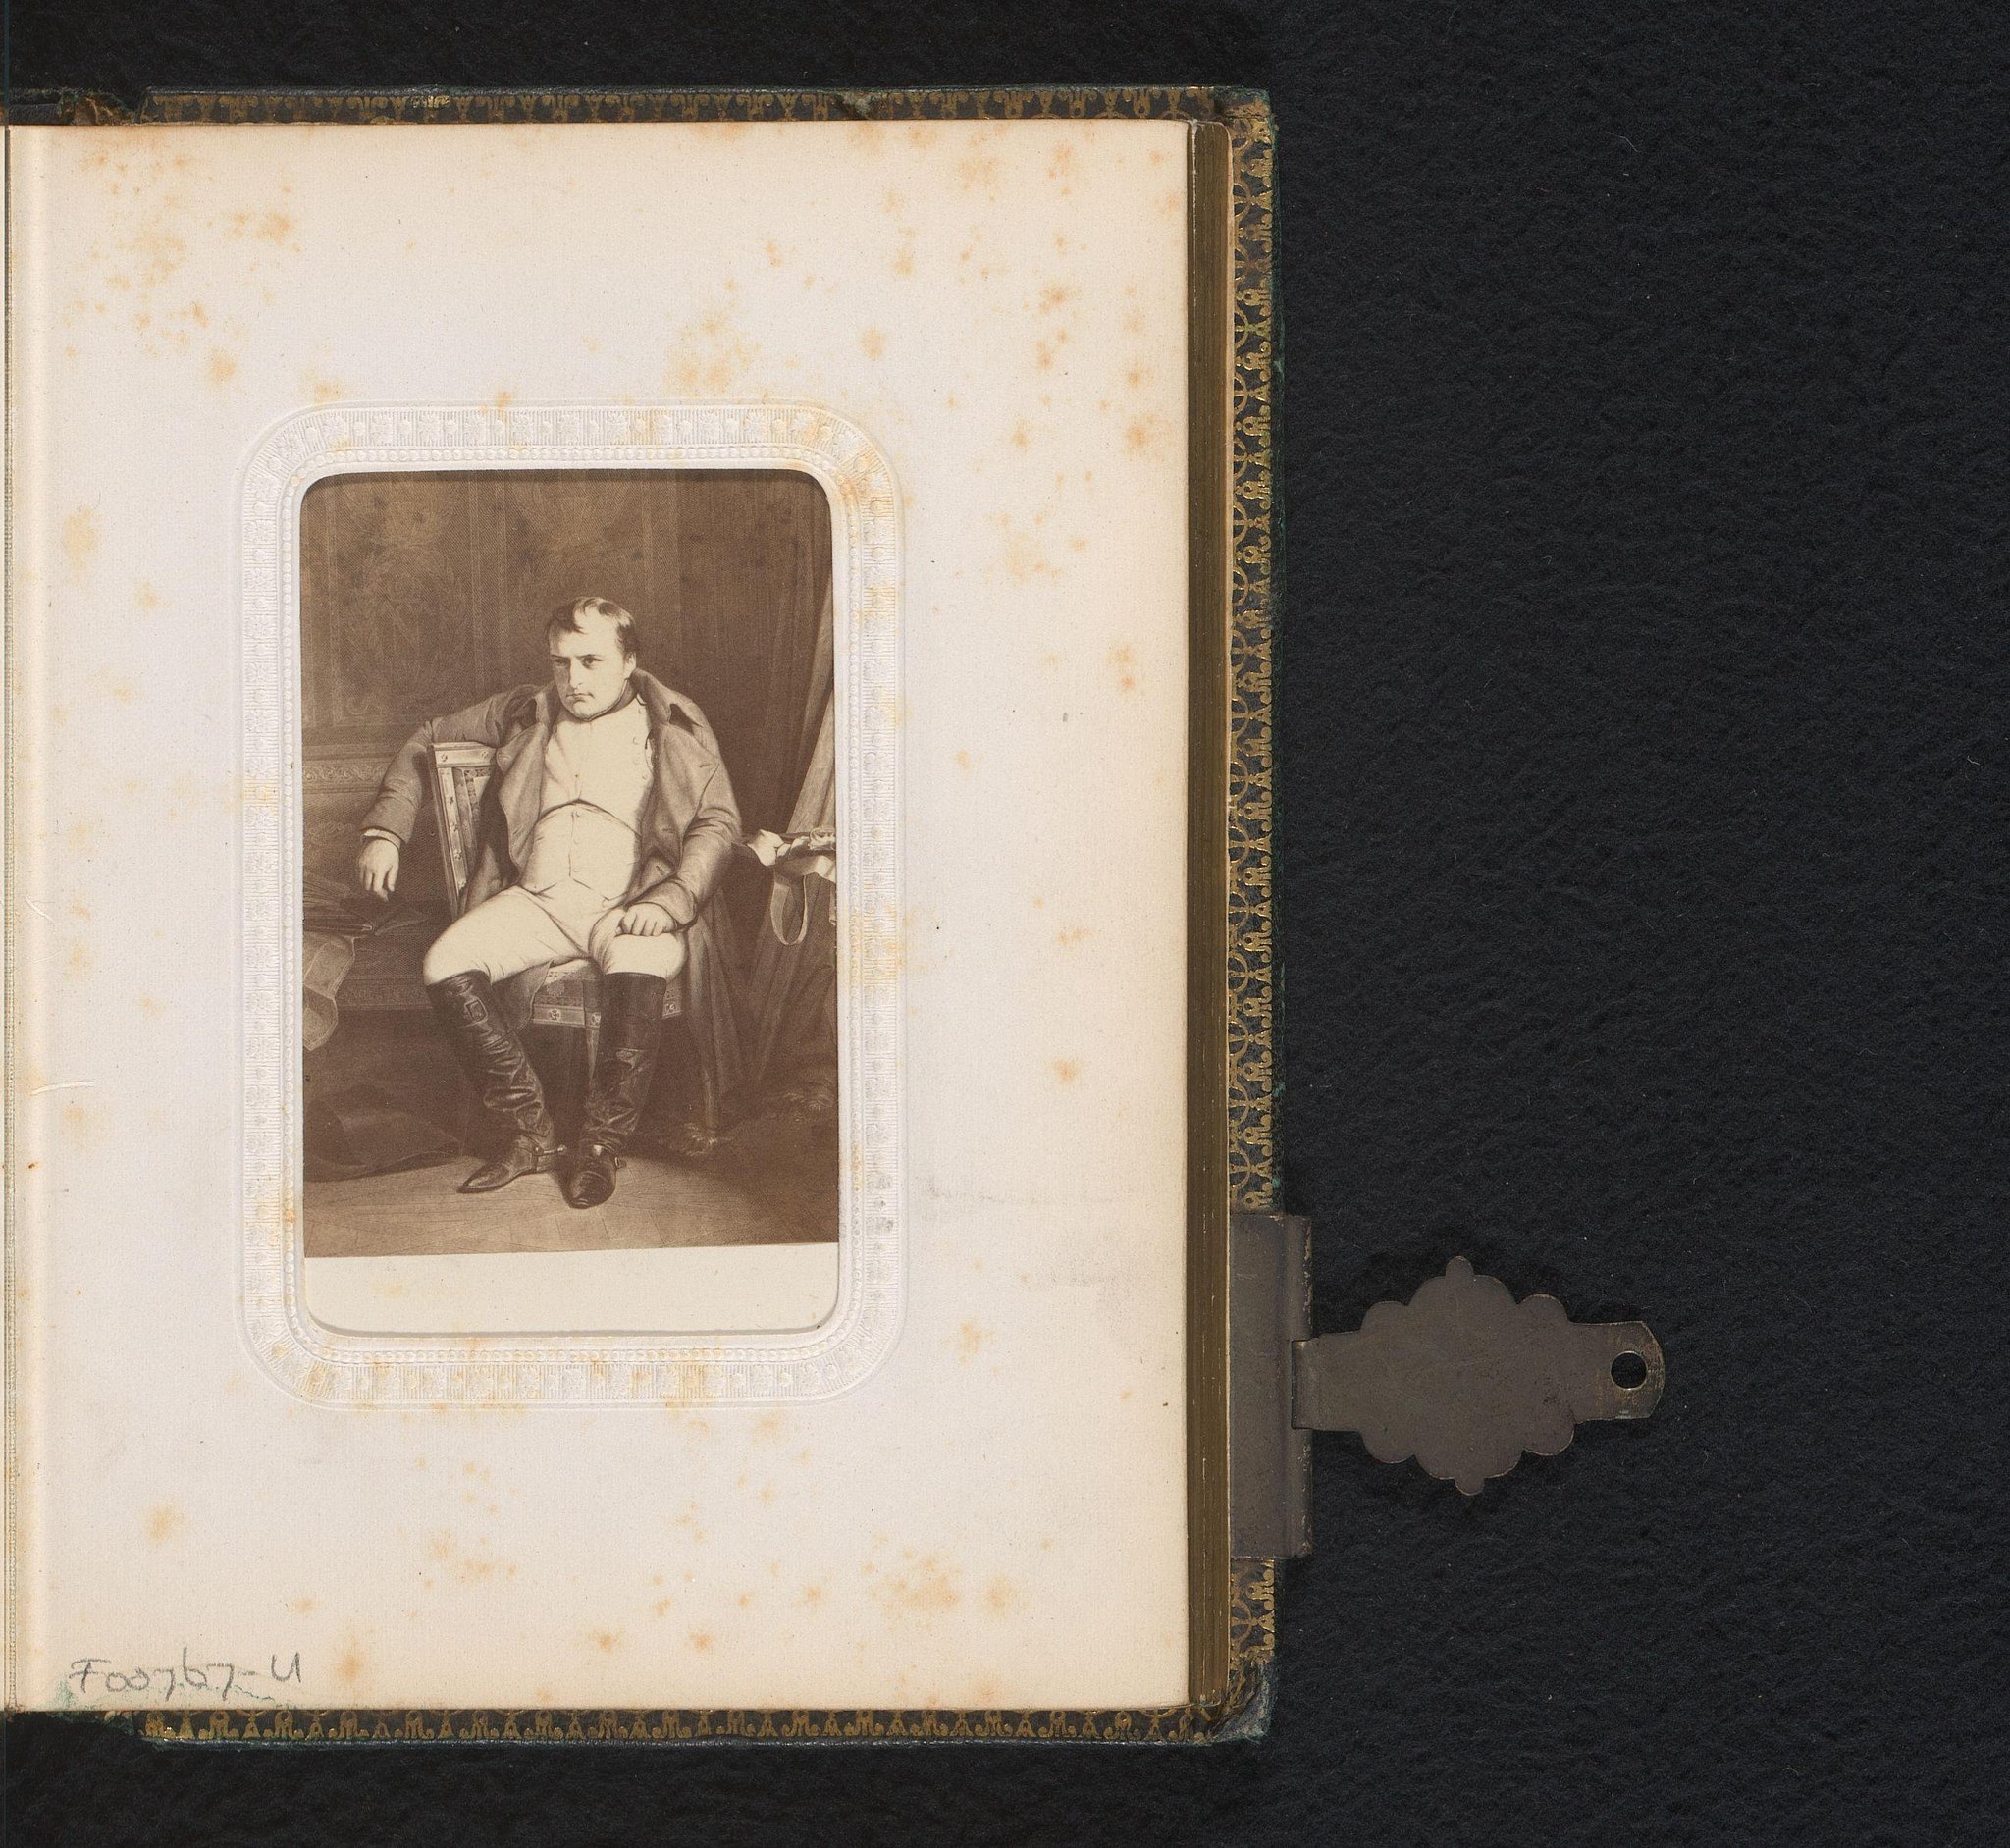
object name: photograph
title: Fotoreproductie van een schilderij van Napoleon Bonaparte in Fontainebleau, 31 maart 1814 door Paul Delaroche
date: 1861-1878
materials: cardboard, photographic support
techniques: albumen print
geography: paris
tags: napoleon i (emperor of the french), standing figure, historical persons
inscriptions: inscription: ‘PHOTOGRAPHIE GOUPIL & Cie/ PARIS, 19, Bd Montmartre./ LONDRES-LA HAYE-BERLIN-NEW YORK’